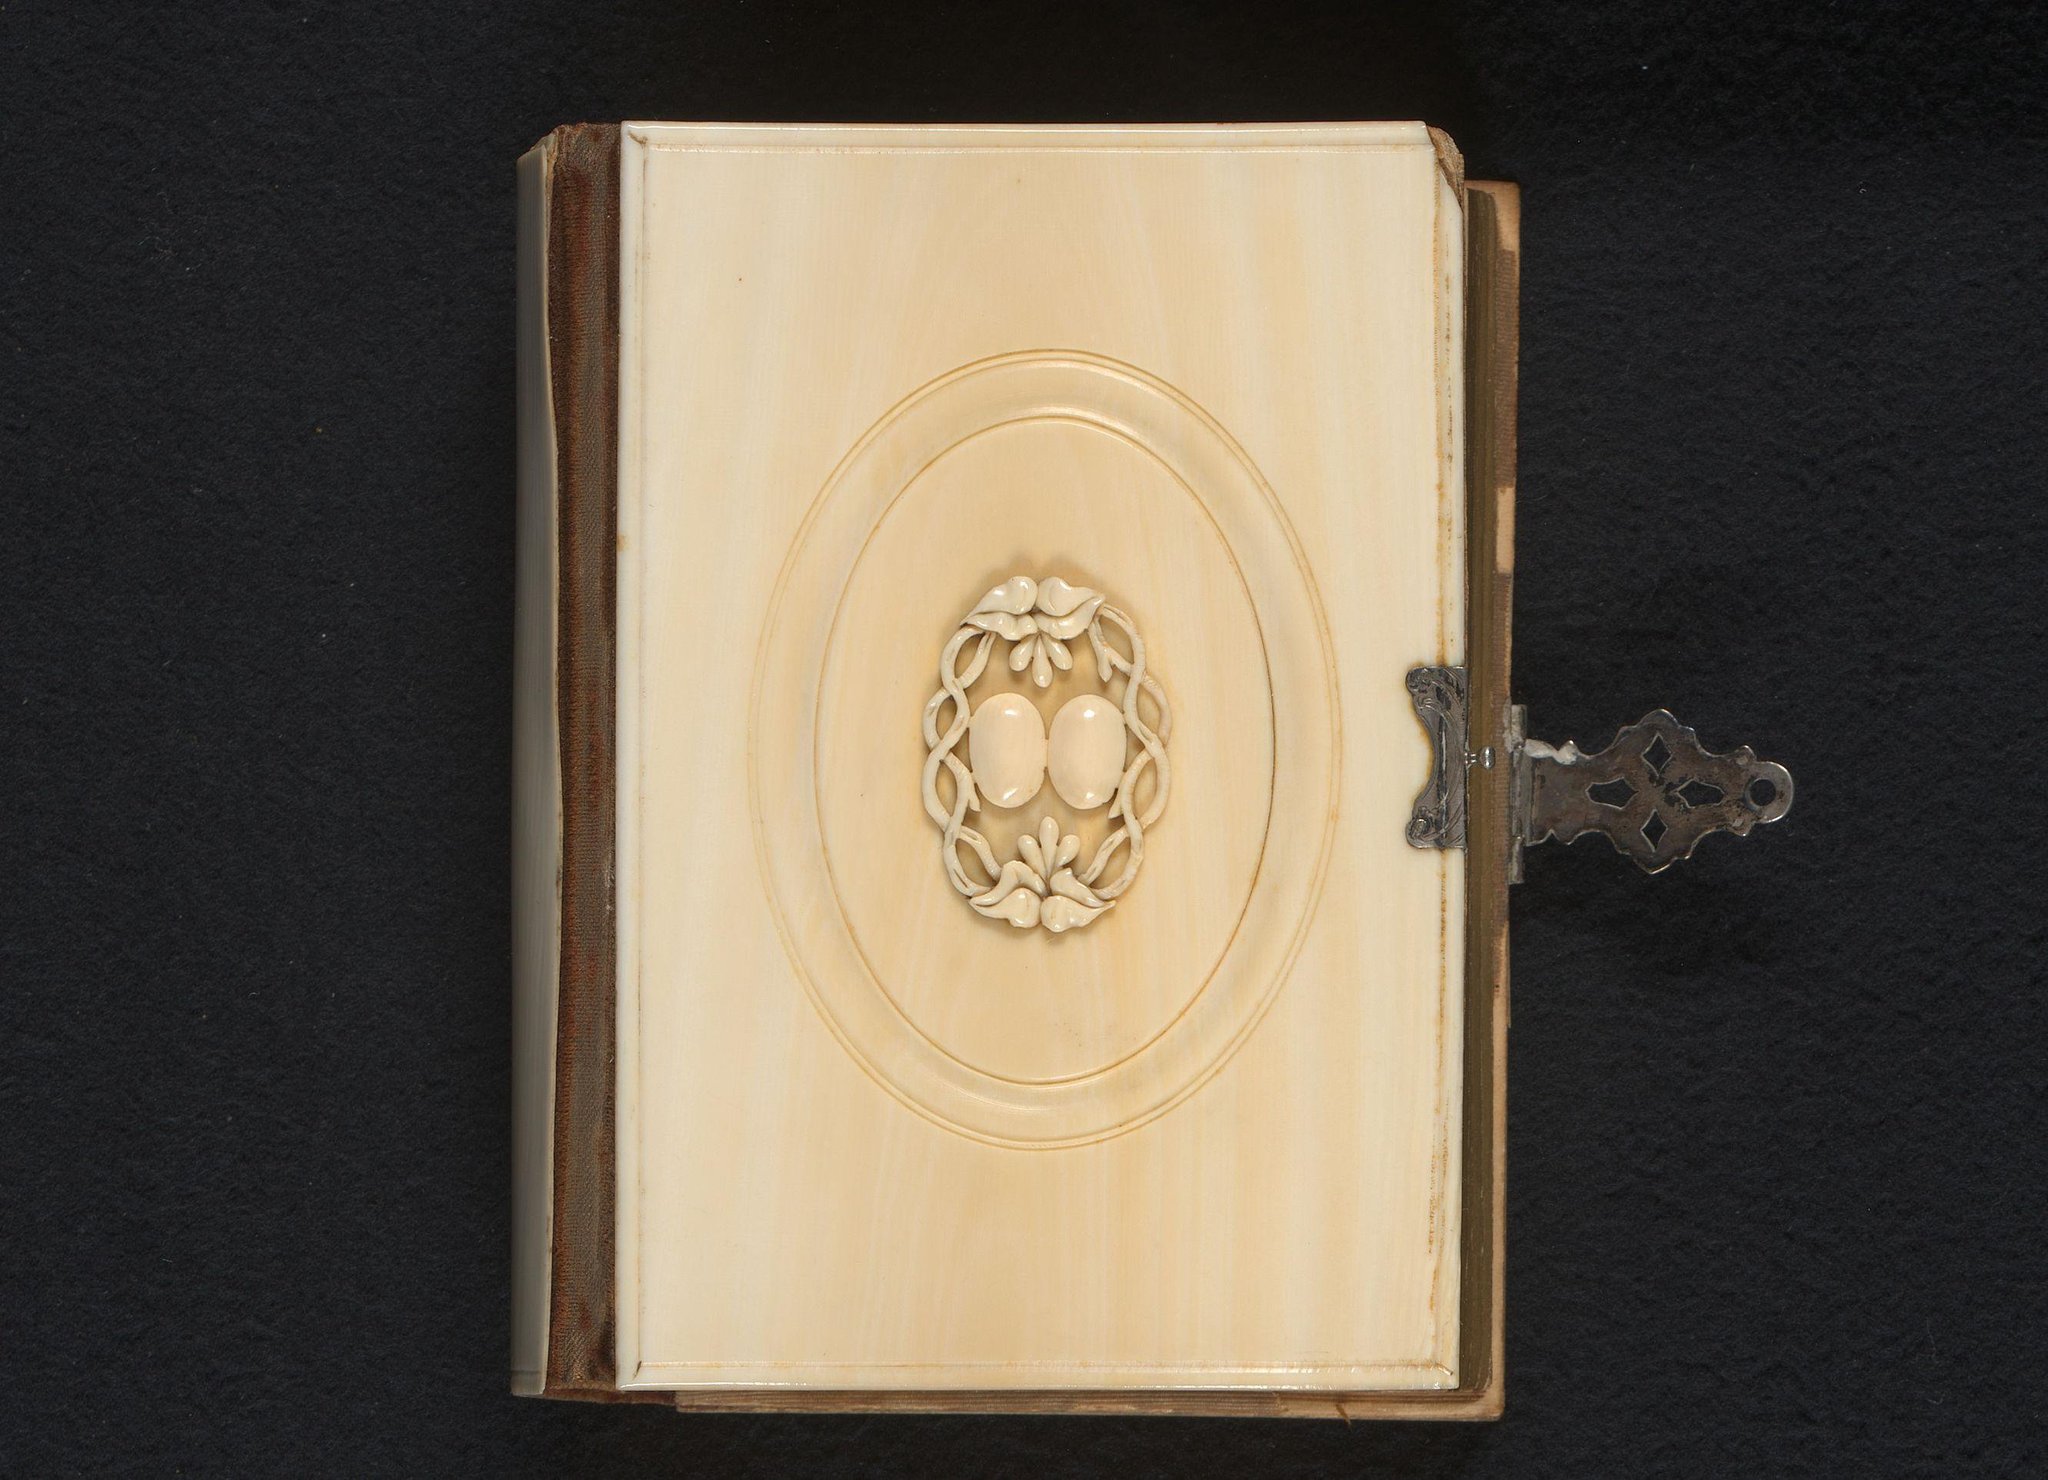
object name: photograph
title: Familiealbum met 20 foto's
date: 1860-1910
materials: cardboard, ivory, metal, photographic support, textile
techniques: albumen print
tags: adult woman, chess, adult man, girl (child between toddler and youth), chair, dog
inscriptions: inscription: ‘Dienst Verspreide Rijkskollektie (...)’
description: Fotoalbum met 30 pagina's met in totaal 20 foto's, alle cartes-de-visite. Het album bevat voornamelijk portretten van een mannen, vrouwen en kinderen, maar ook een fotoreproductie van een schilderij en een post-mortemportret van een kind.